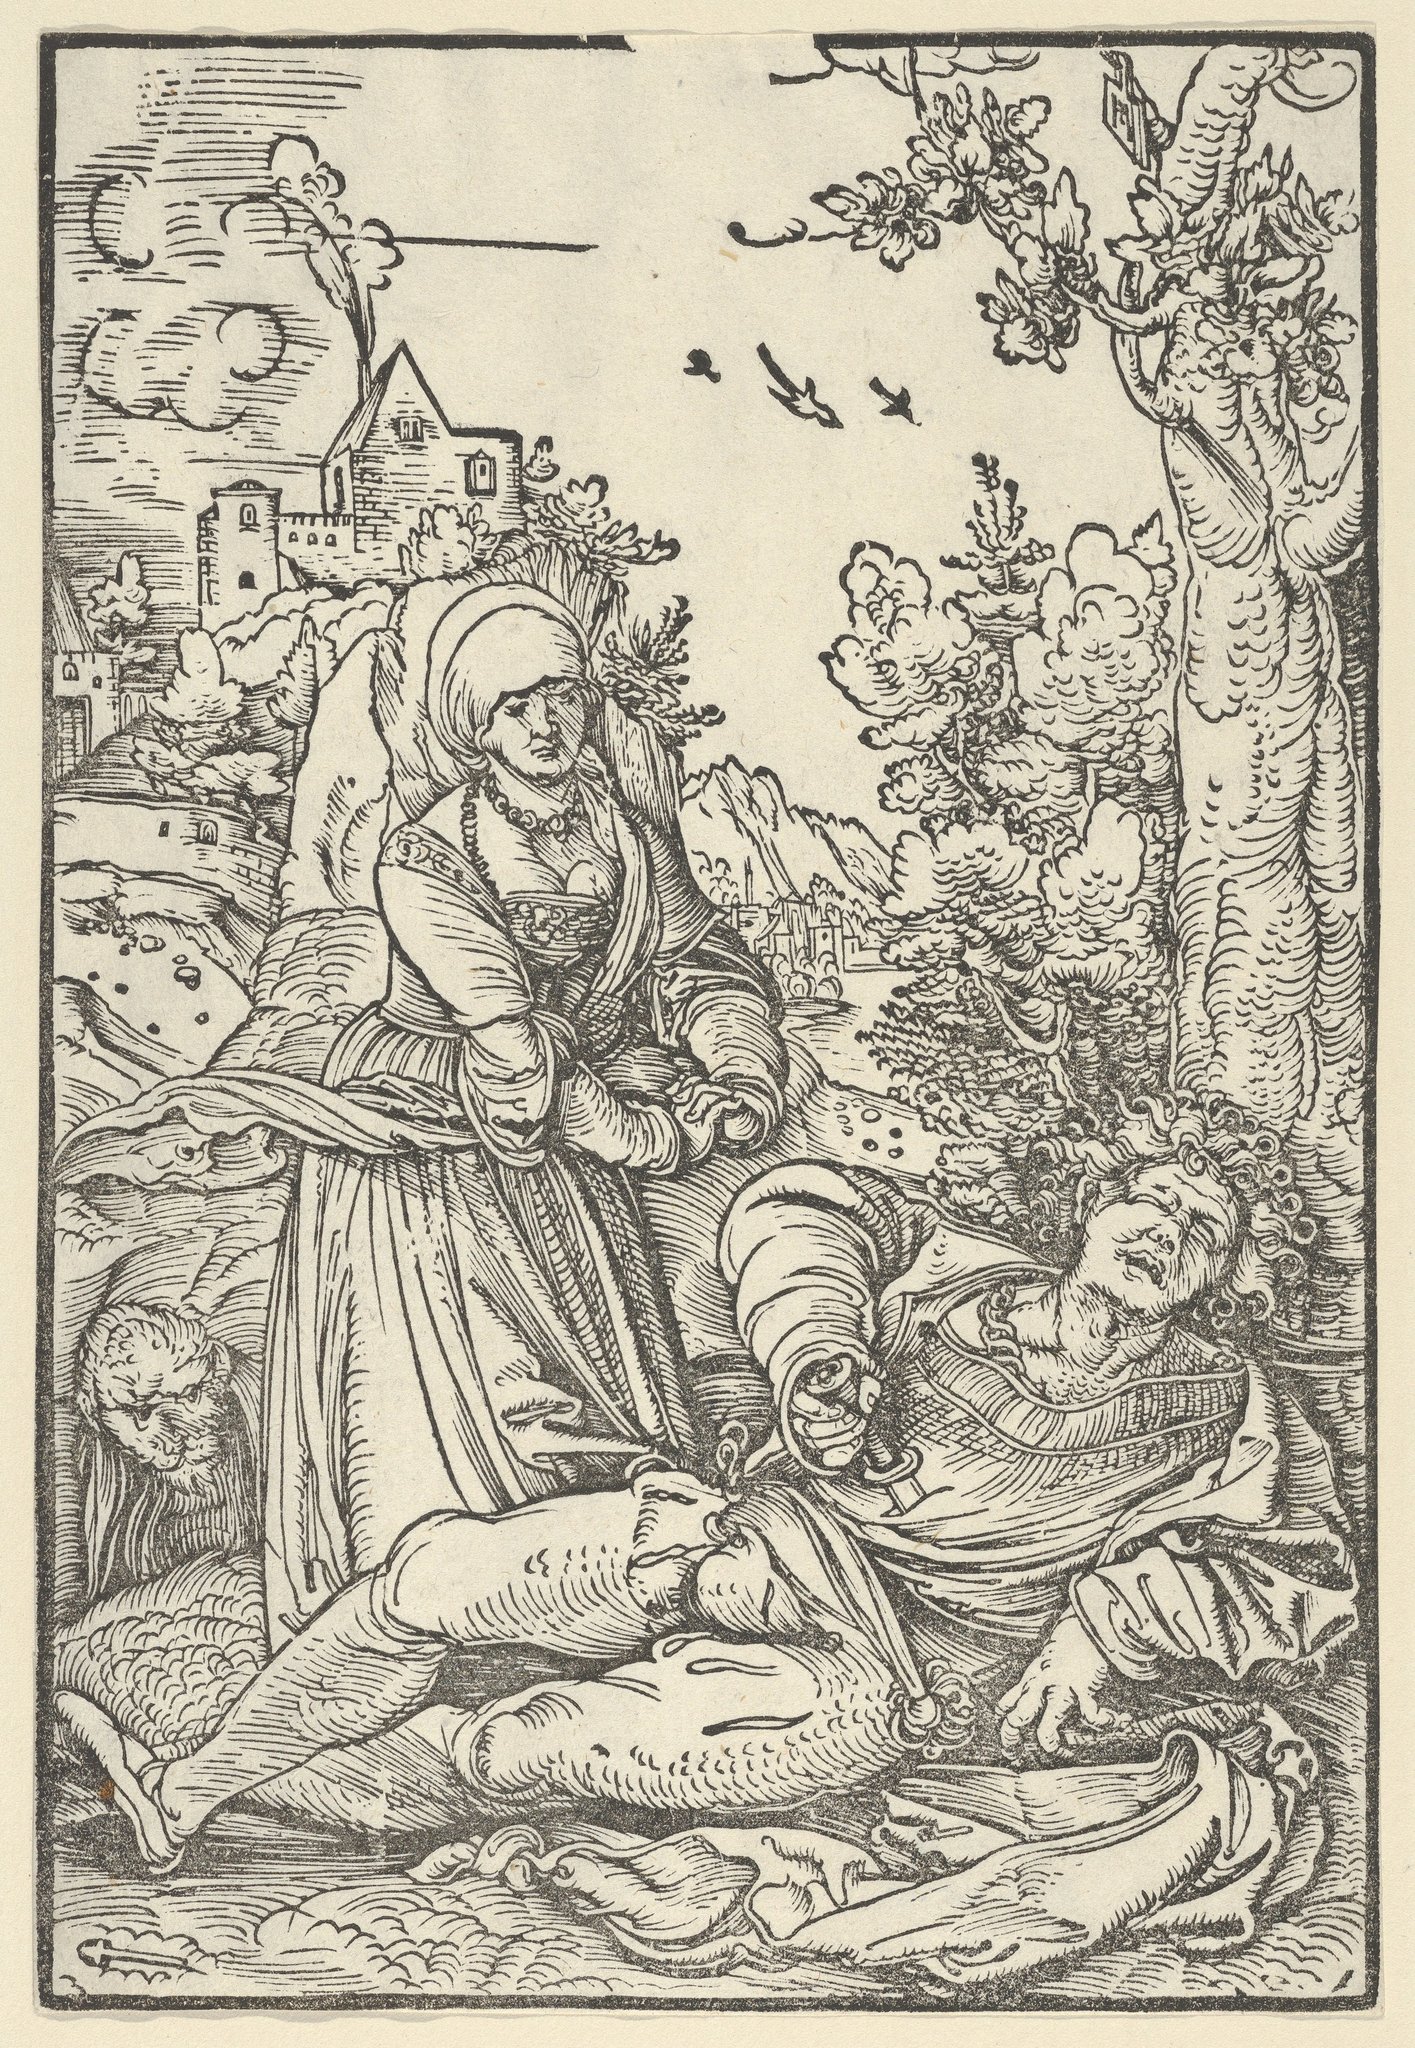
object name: print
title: Pyramus and Thisbe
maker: hans schäufelein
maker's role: artist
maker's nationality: german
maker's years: 1480-1540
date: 1509-1510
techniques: woodcut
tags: men,lovers,women